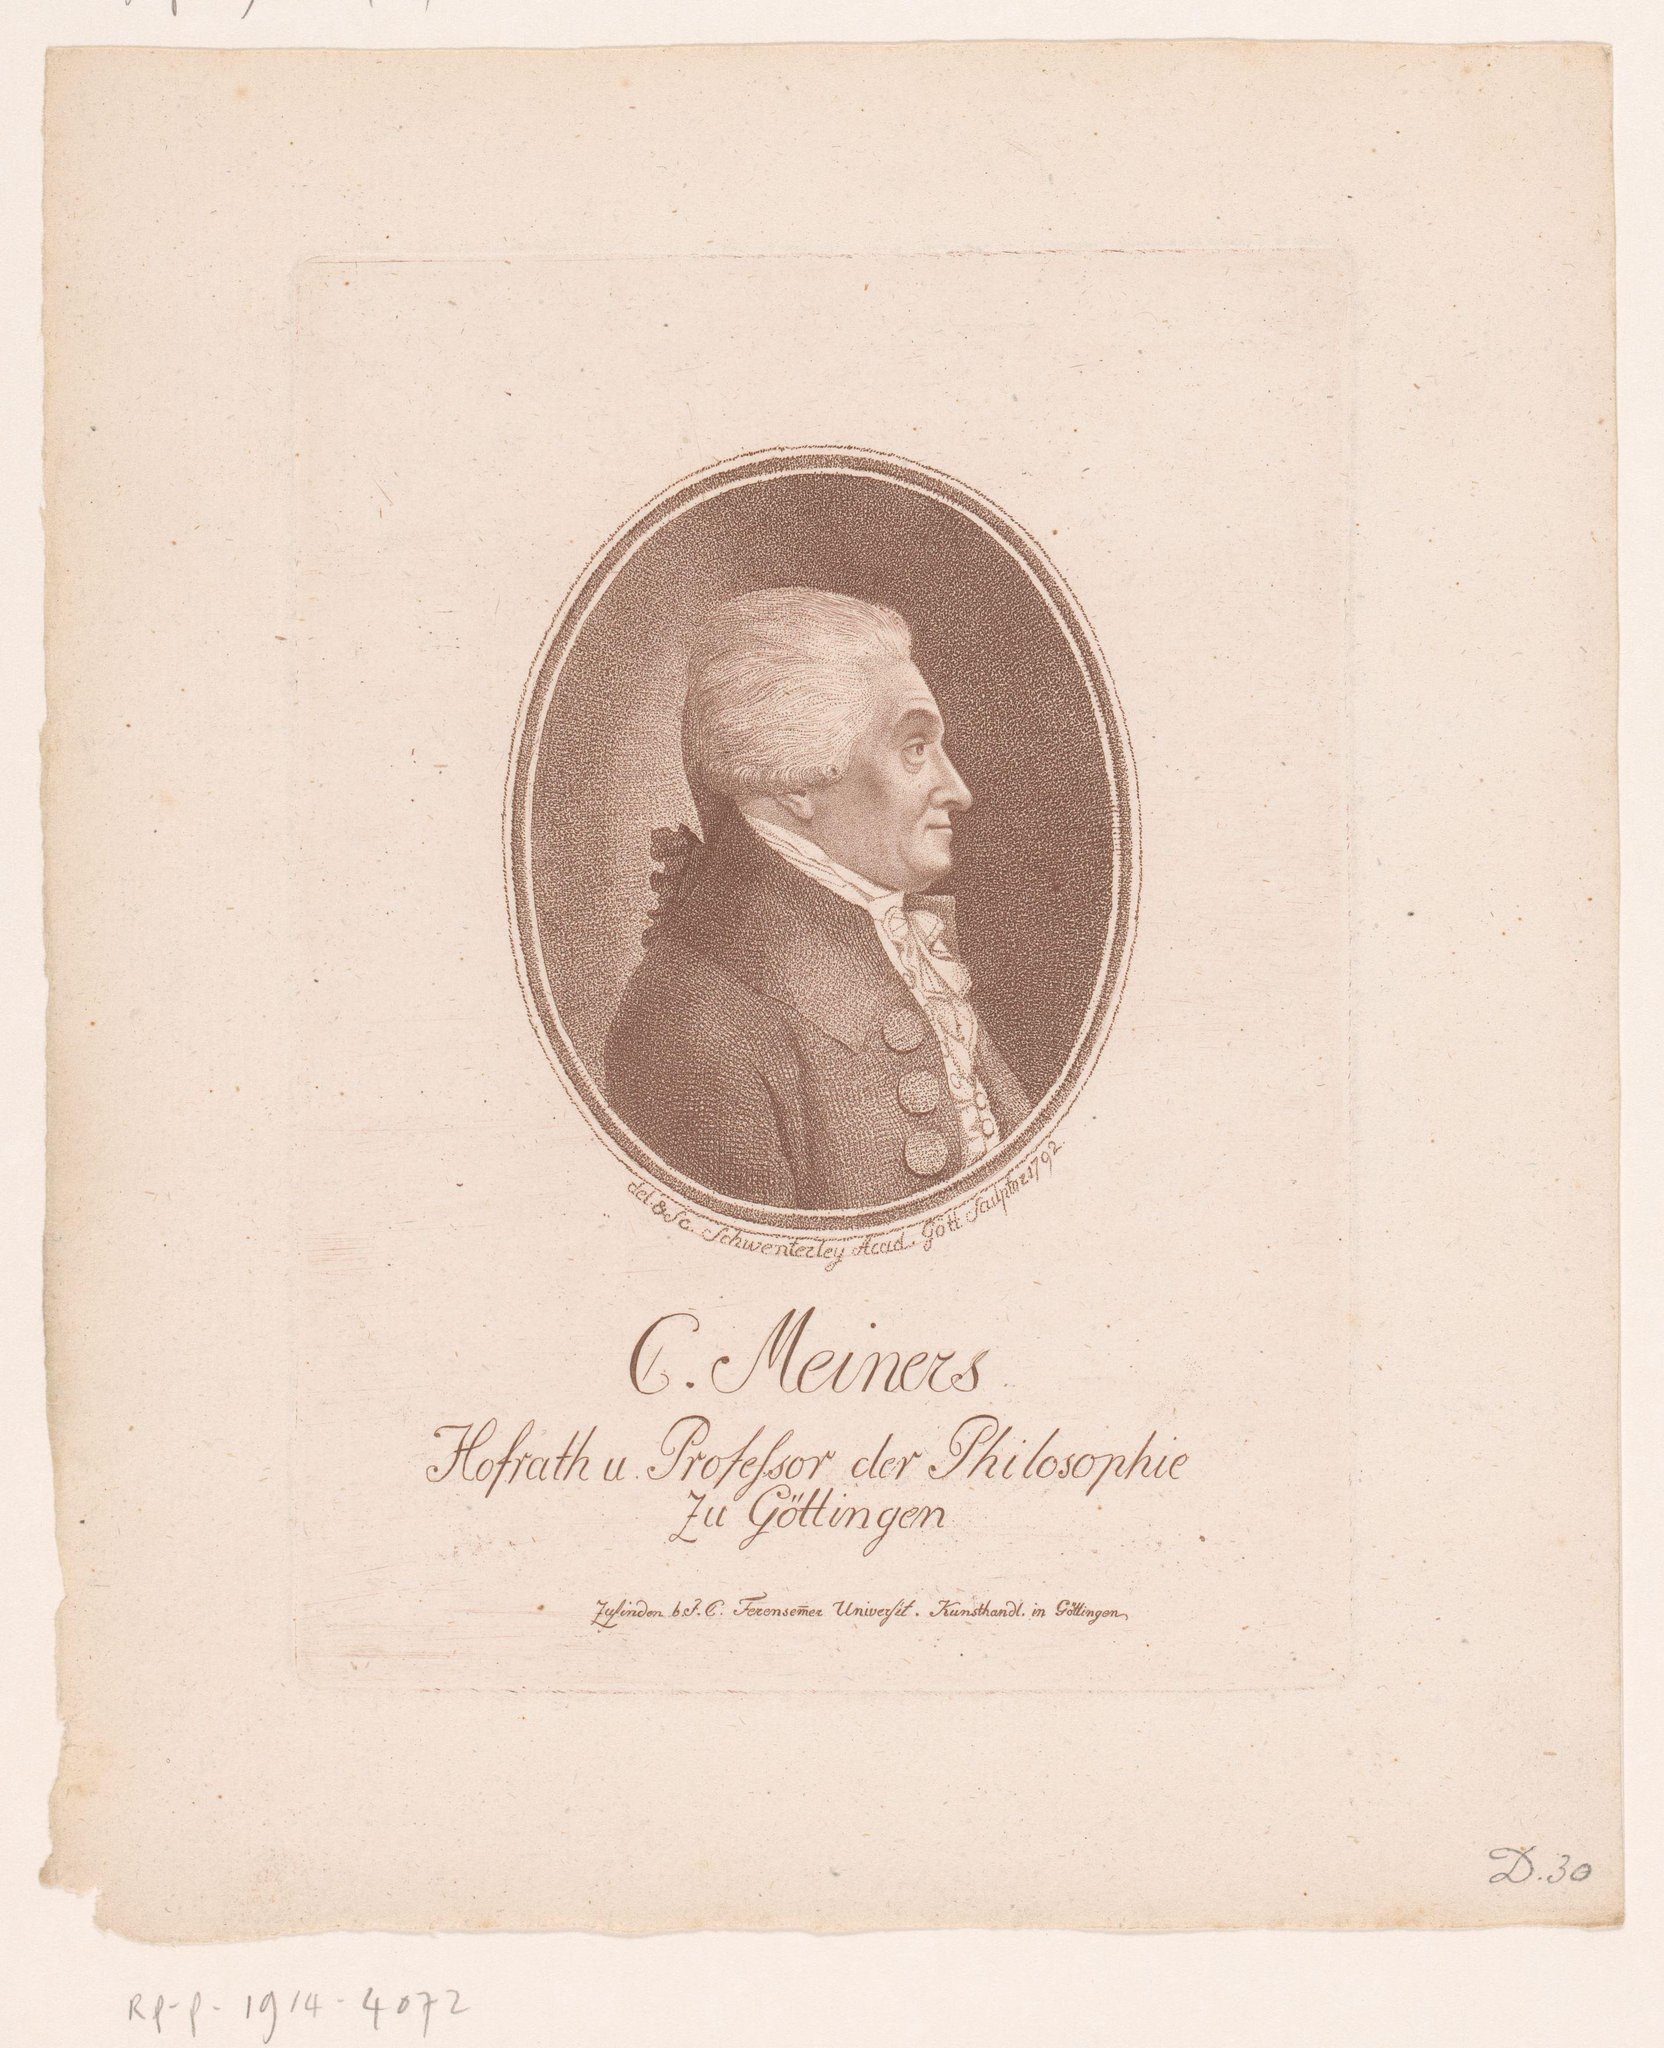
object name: print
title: Portret van Christoph Meiners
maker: heinrich schwenterley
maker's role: print maker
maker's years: 1749-1815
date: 1792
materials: paper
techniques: stippling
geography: gottingen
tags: historical persons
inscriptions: collector's mark: Lugt 2228